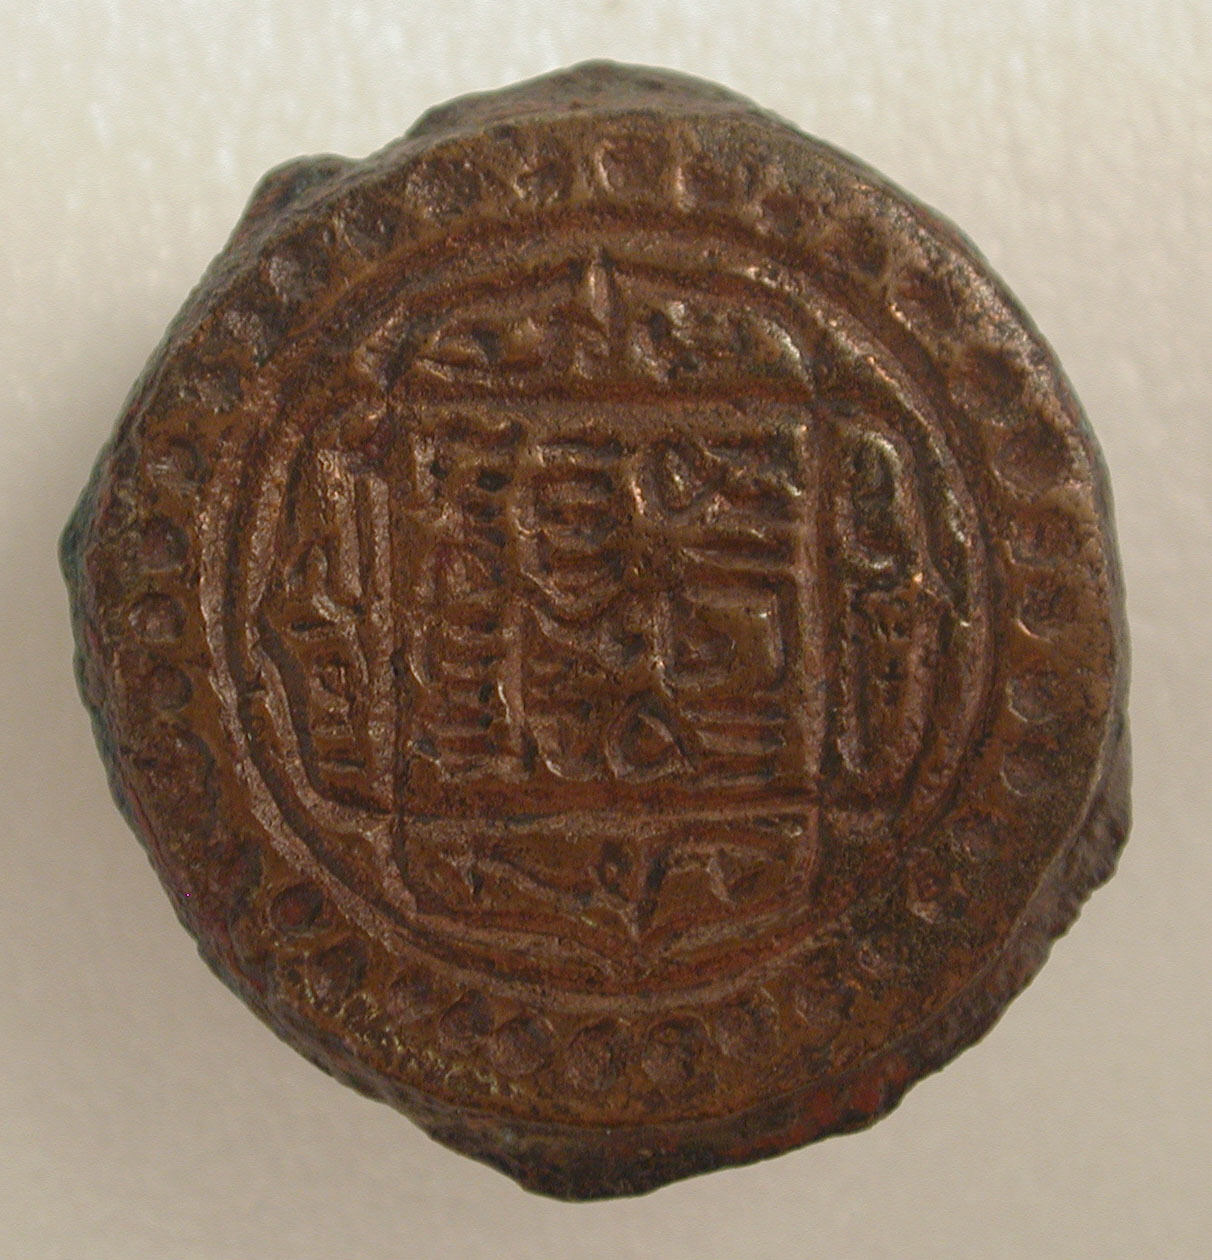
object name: die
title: Die for a Coin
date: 1311-1335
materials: bronze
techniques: casting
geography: iran